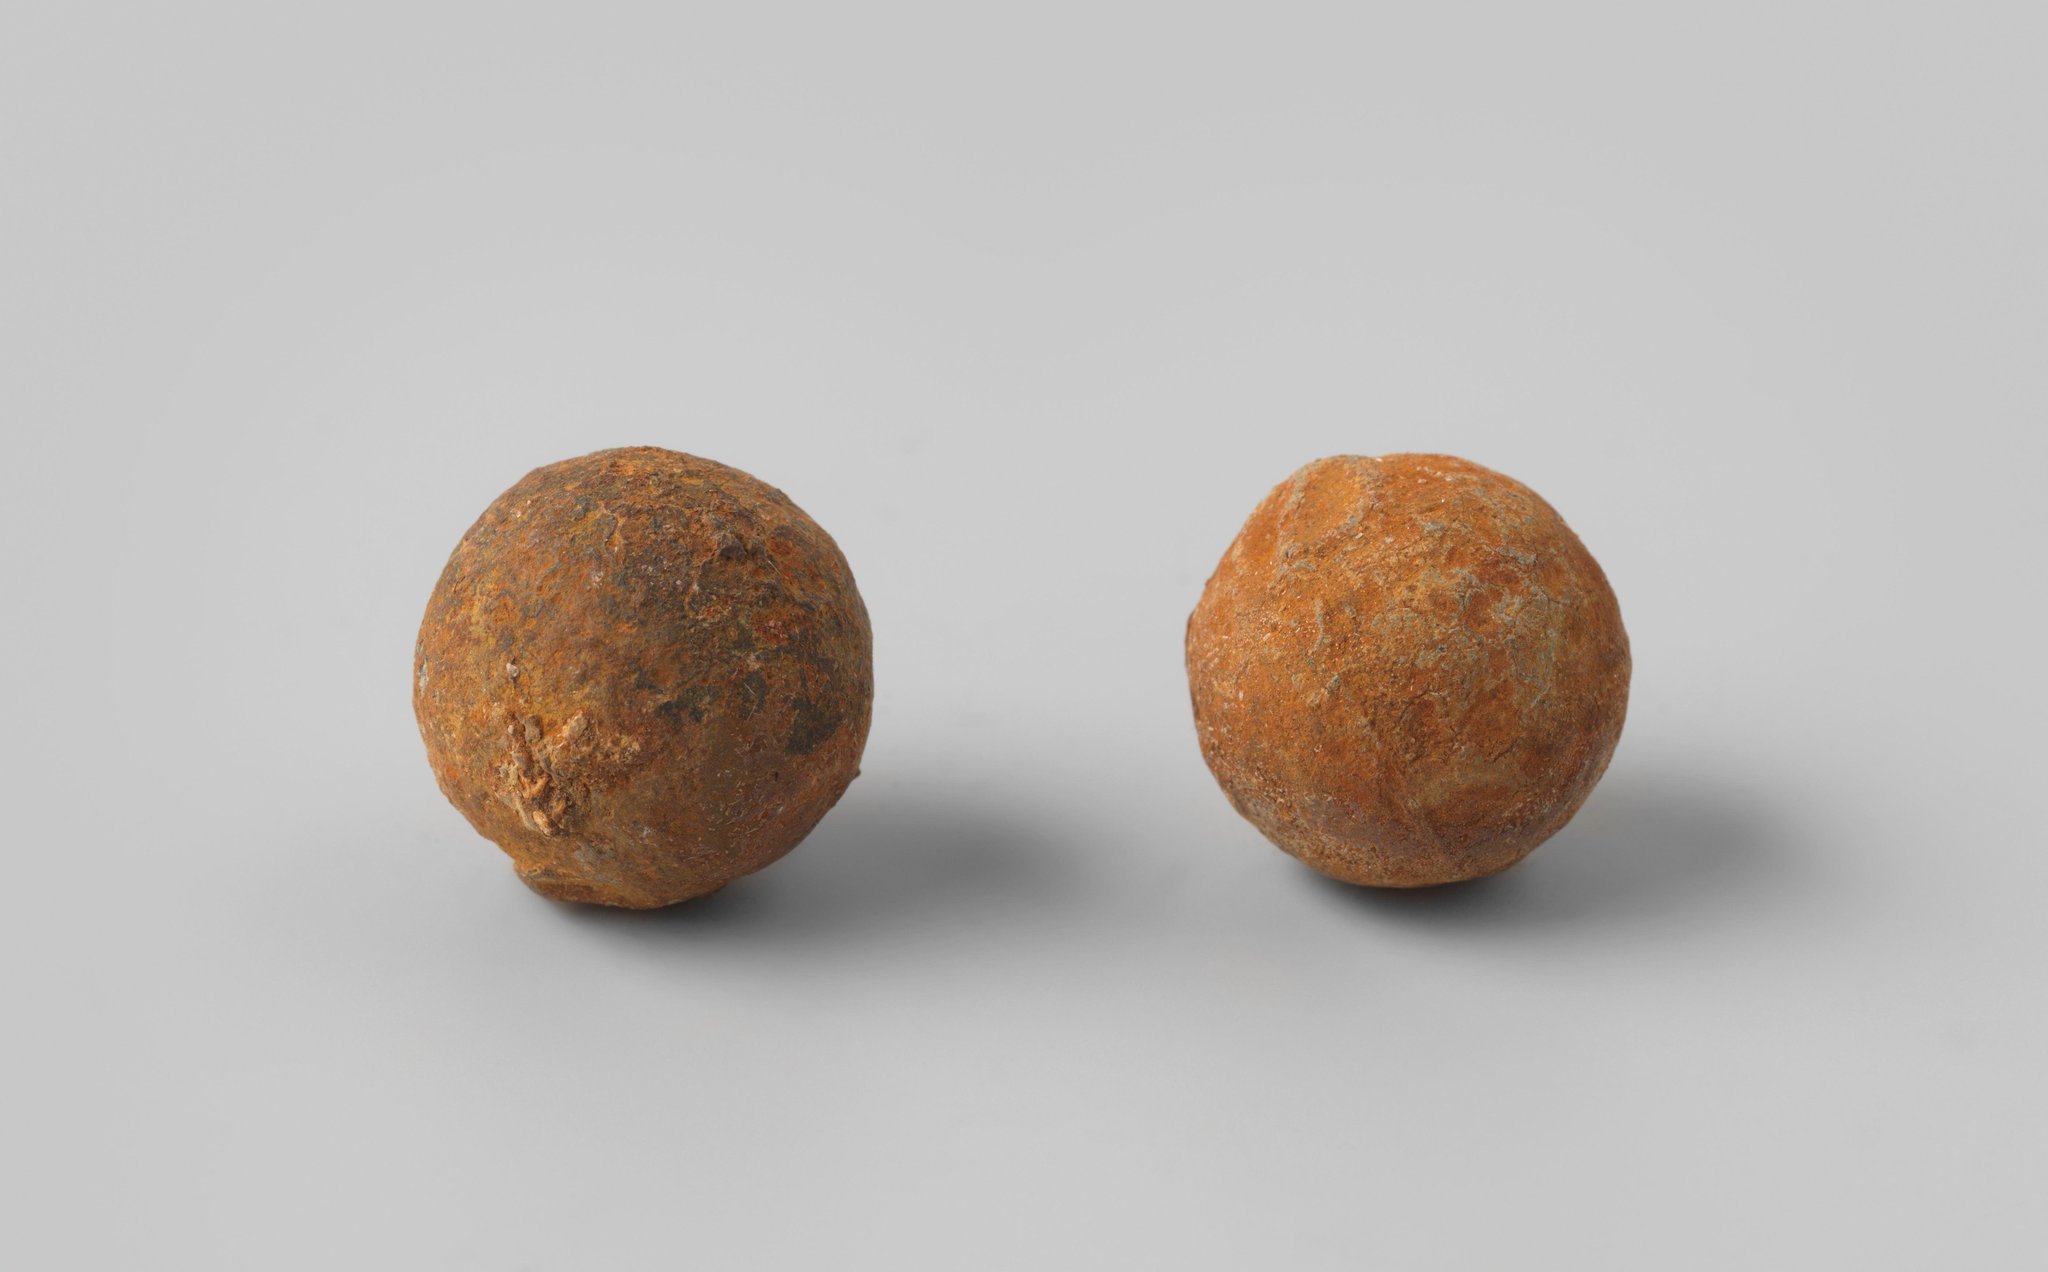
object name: musketkogel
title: Musketkogels uit het wrak van de Oost-Indiëvaarder Hollandia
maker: Anonymous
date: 1700-1743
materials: lead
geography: netherlands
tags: verenigde oostindische compagnie, hollandia (schip), annet